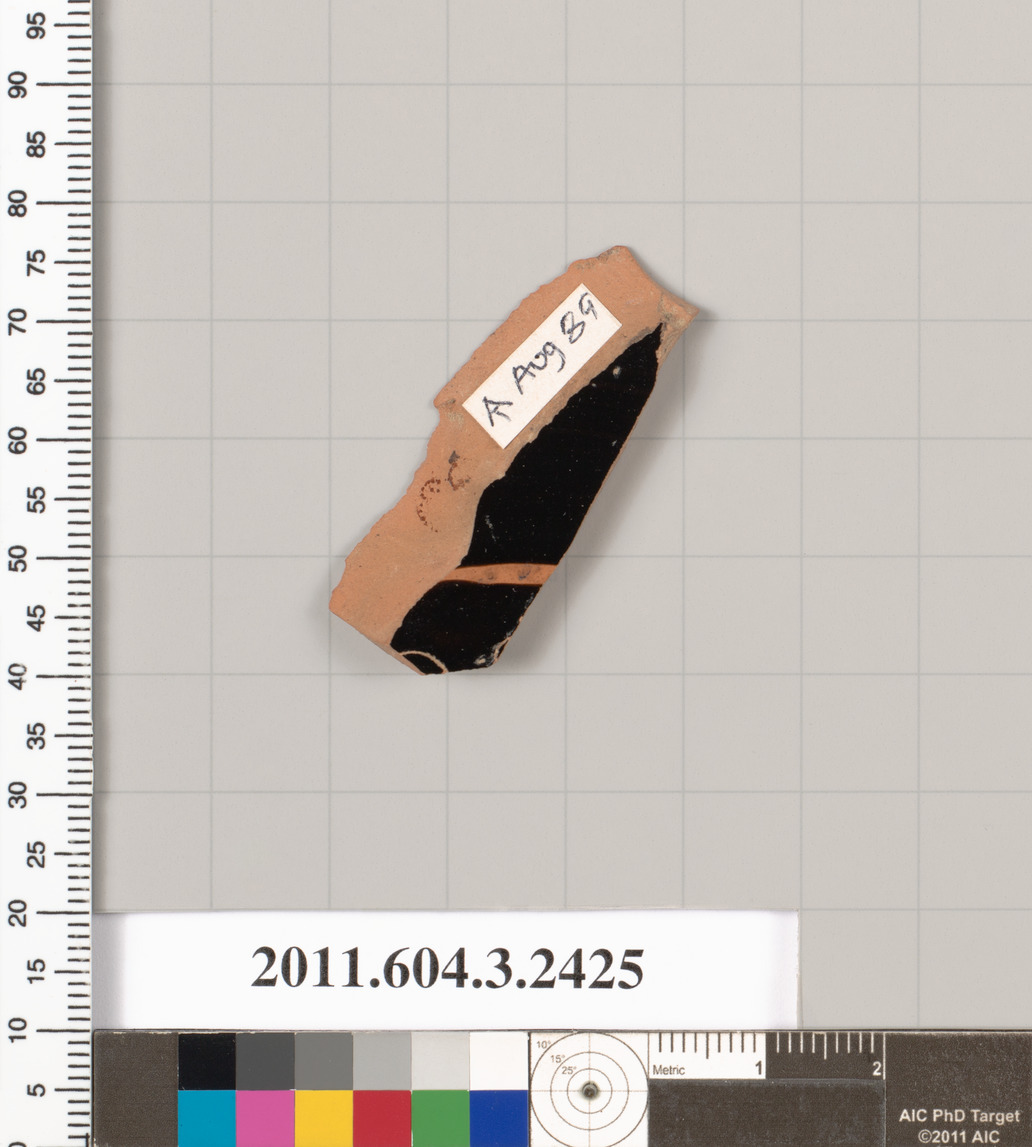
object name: kylix fragment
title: Terracotta fragment of a kylix: eye-cup (drinking cup)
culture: greek, attic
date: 530-520 BCE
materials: terracotta